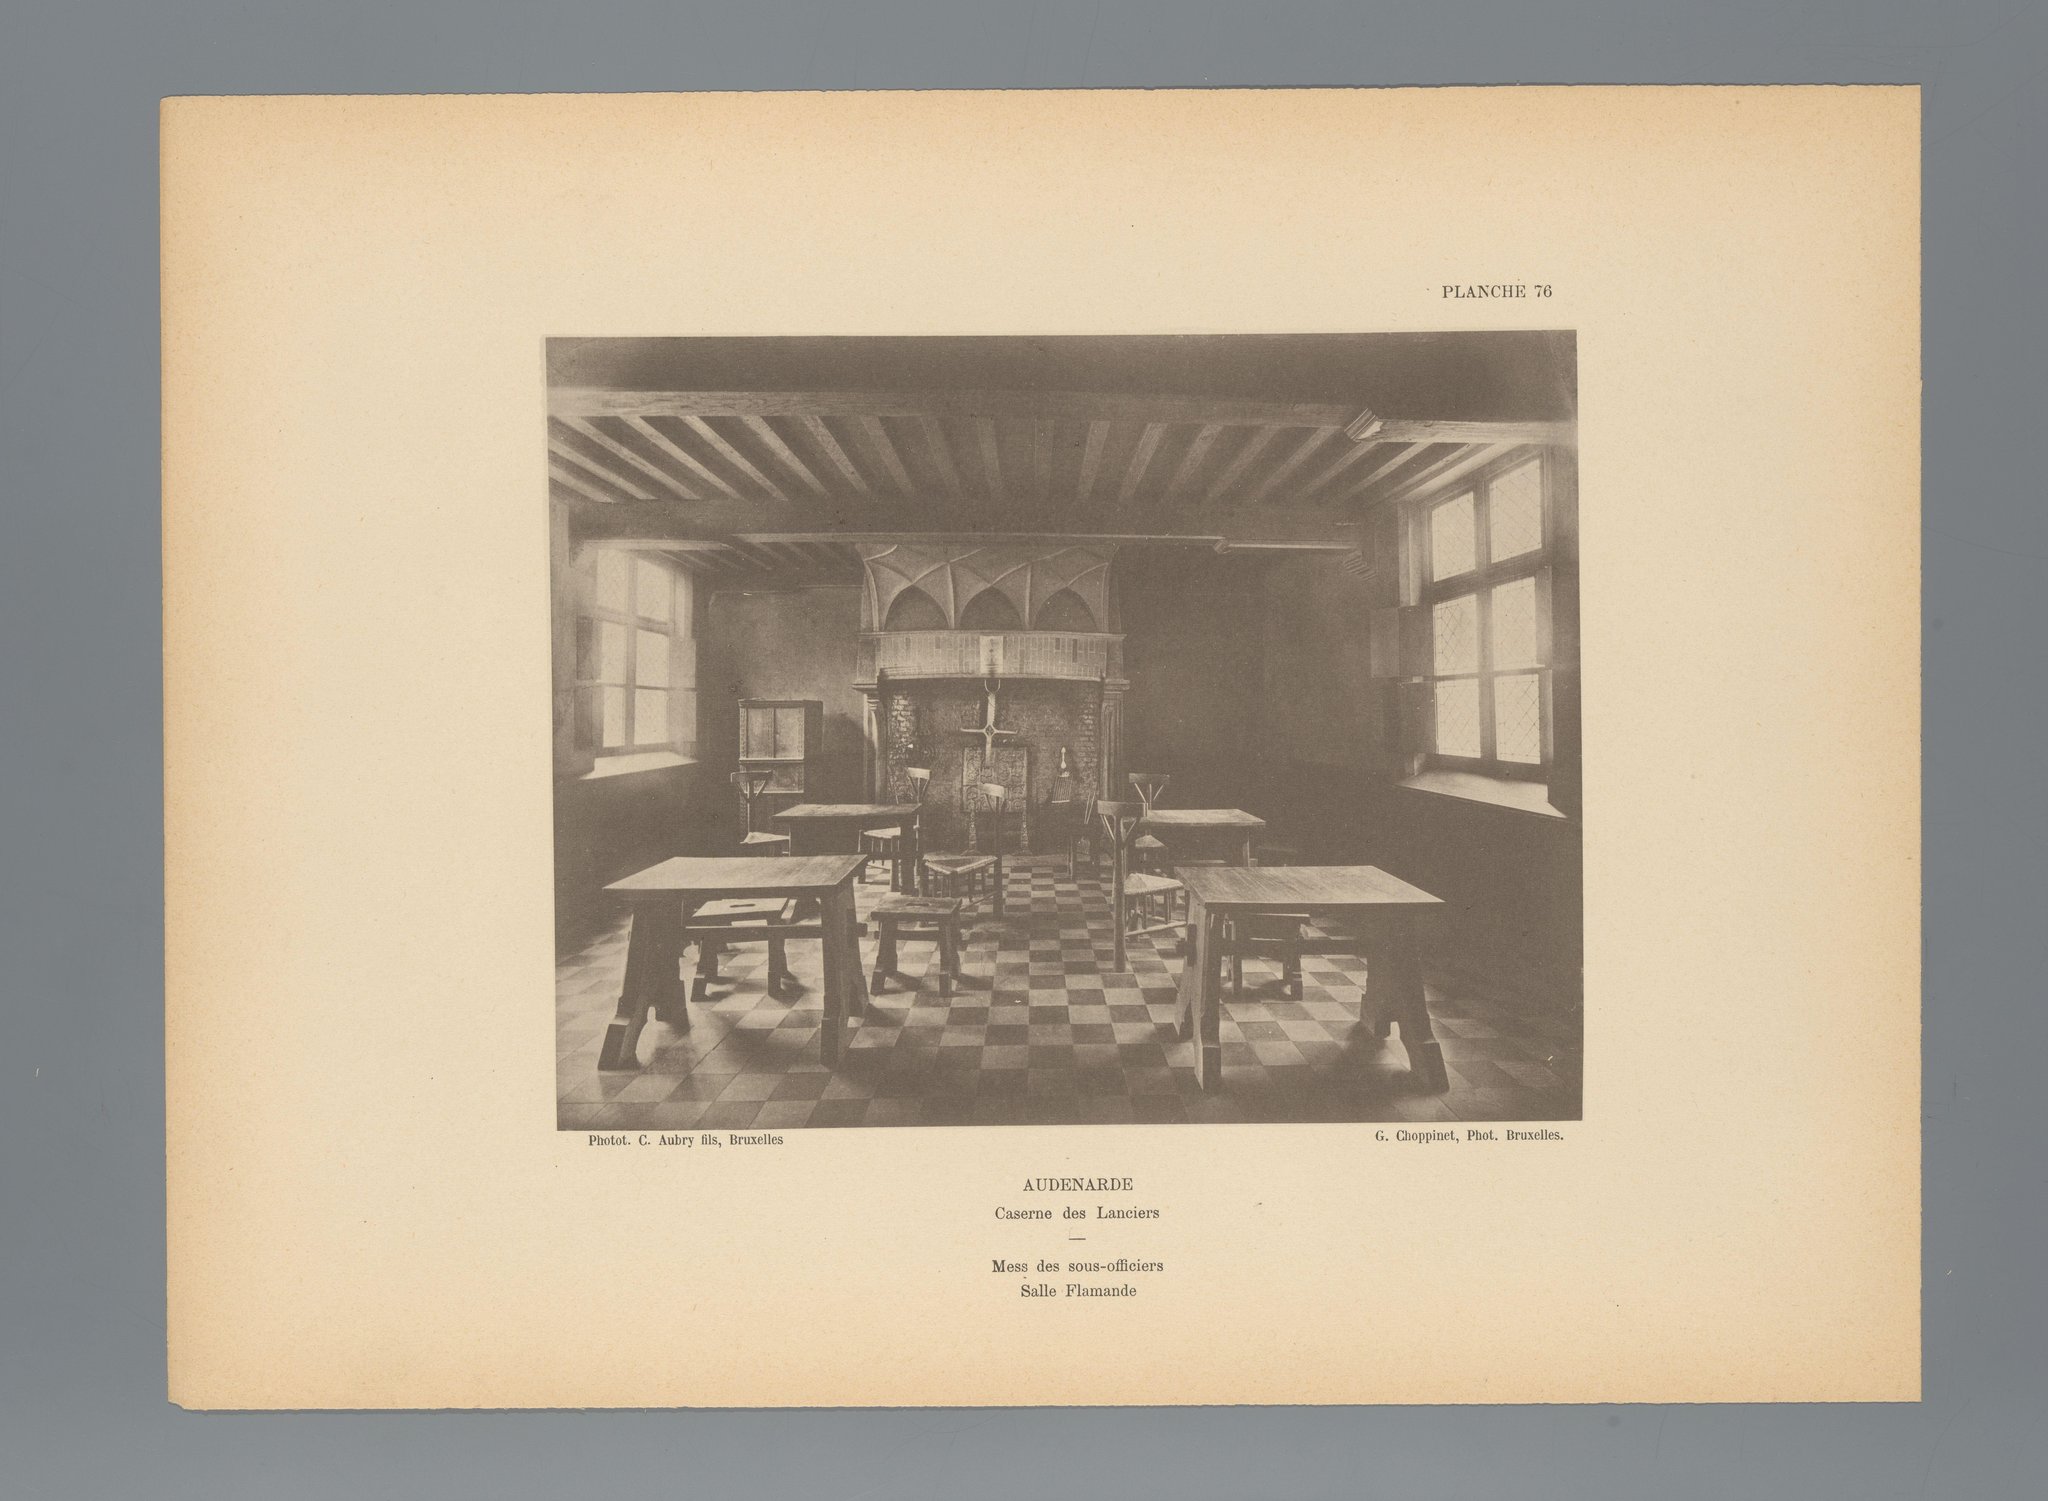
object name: photomechanical print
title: Gezicht op een eetzaal voor onderofficiers in een kazerne in Oudenaarde, België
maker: gustave choppinet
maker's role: fotograaf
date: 1893-1898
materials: paper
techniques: photograph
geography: oudenaarde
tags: mess ~ the soldier off duty, dining-room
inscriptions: number: ‘PLANCHE 76’, inscription: ‘Caserne des Lanciers/ Mess des sous-officiers/ Salle Flamande’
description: Deze prent maakt deel uit van een omslag met 89 prenten en 5 tekstbladen.